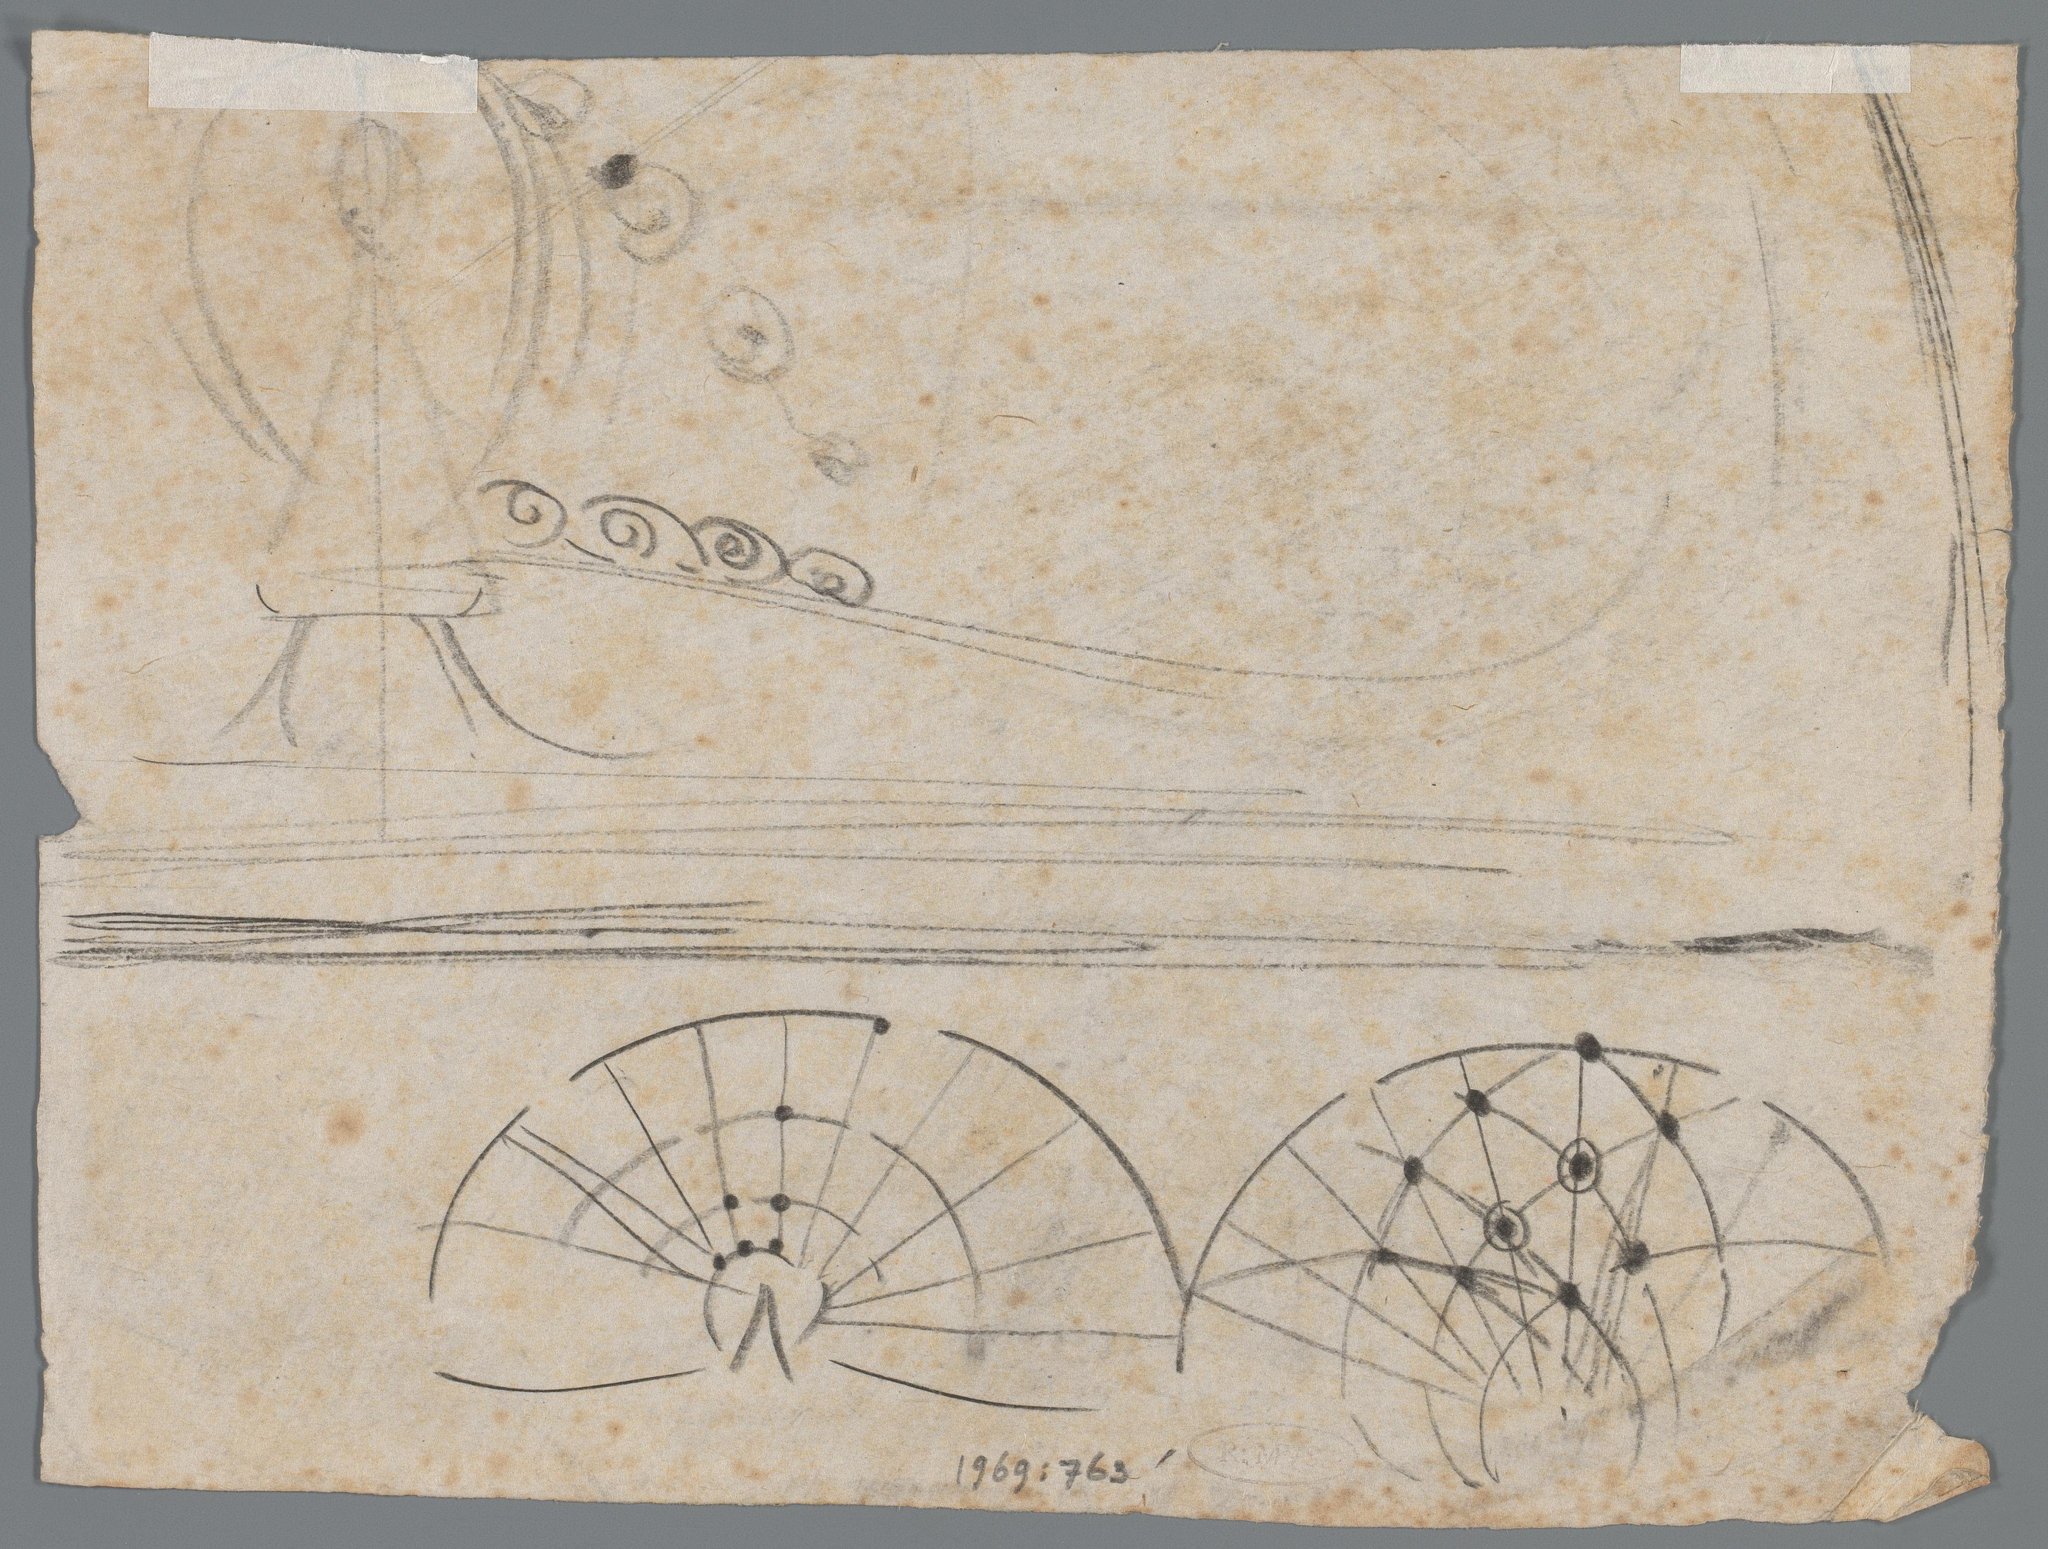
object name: drawing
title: Ornamentstudies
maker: gerrit willem dijsselhof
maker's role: designer, draughtsman, print maker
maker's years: 1866-1924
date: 1876-1924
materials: chalk, paper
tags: ornaments ~ art